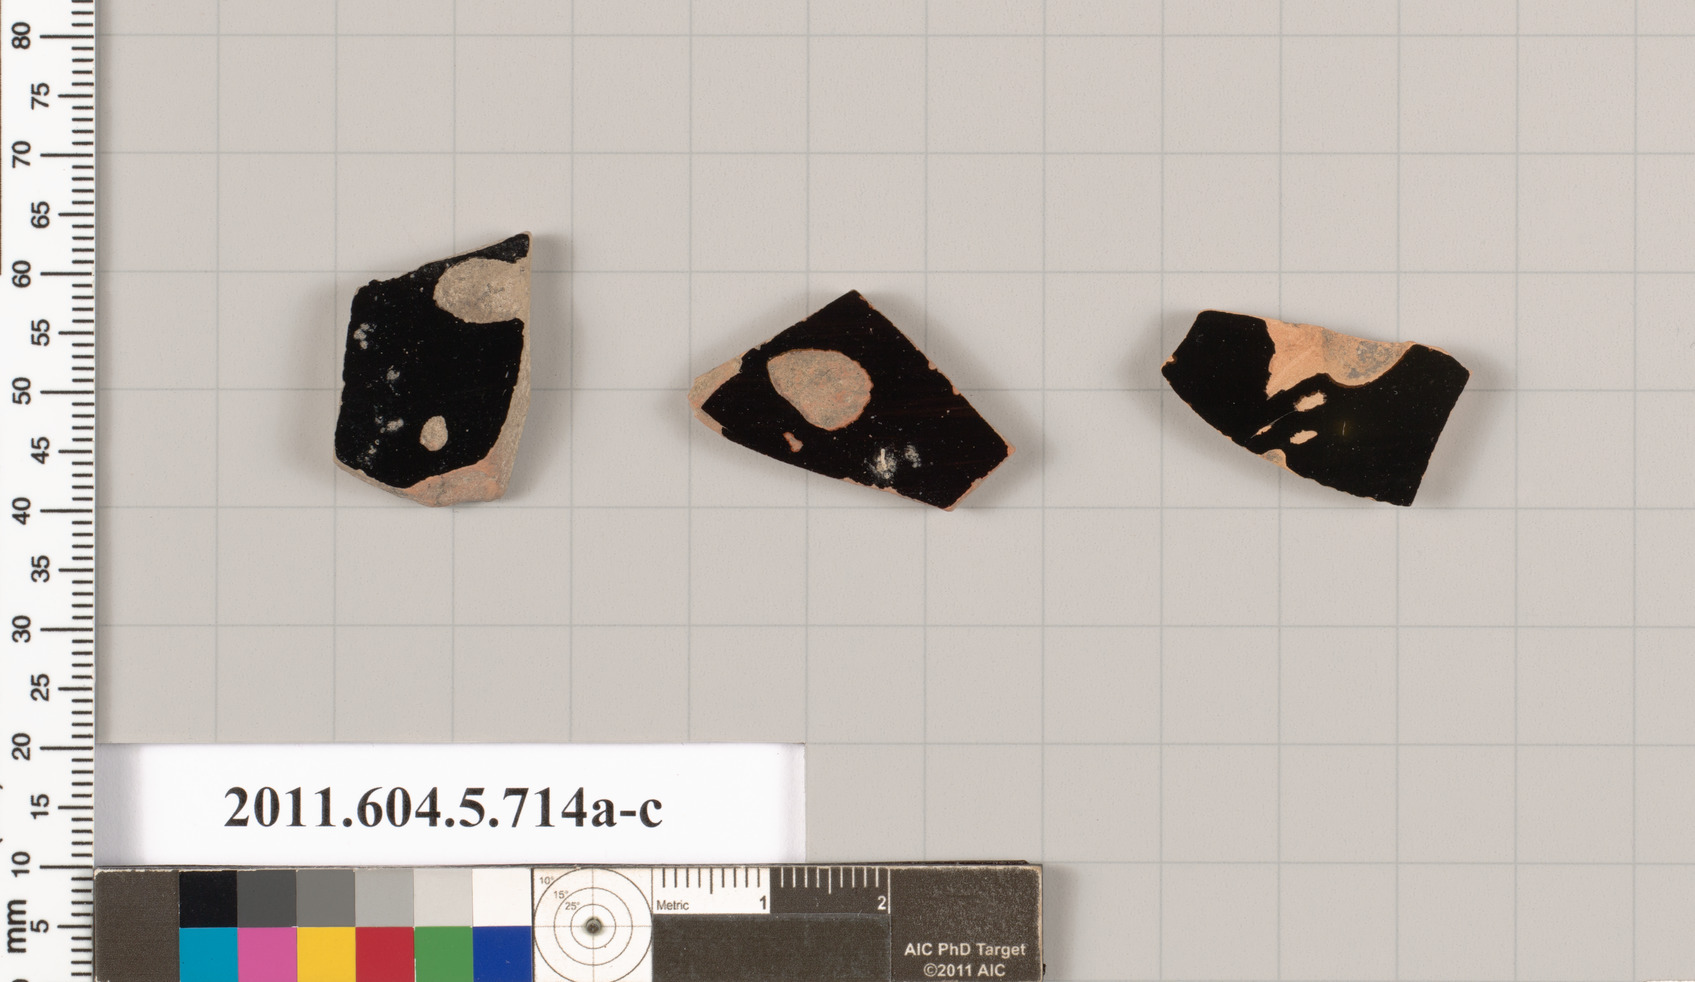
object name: kylix fragment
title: Terracotta fragments of kylikes (drinking cups)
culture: greek, attic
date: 600-401 BCE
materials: terracotta